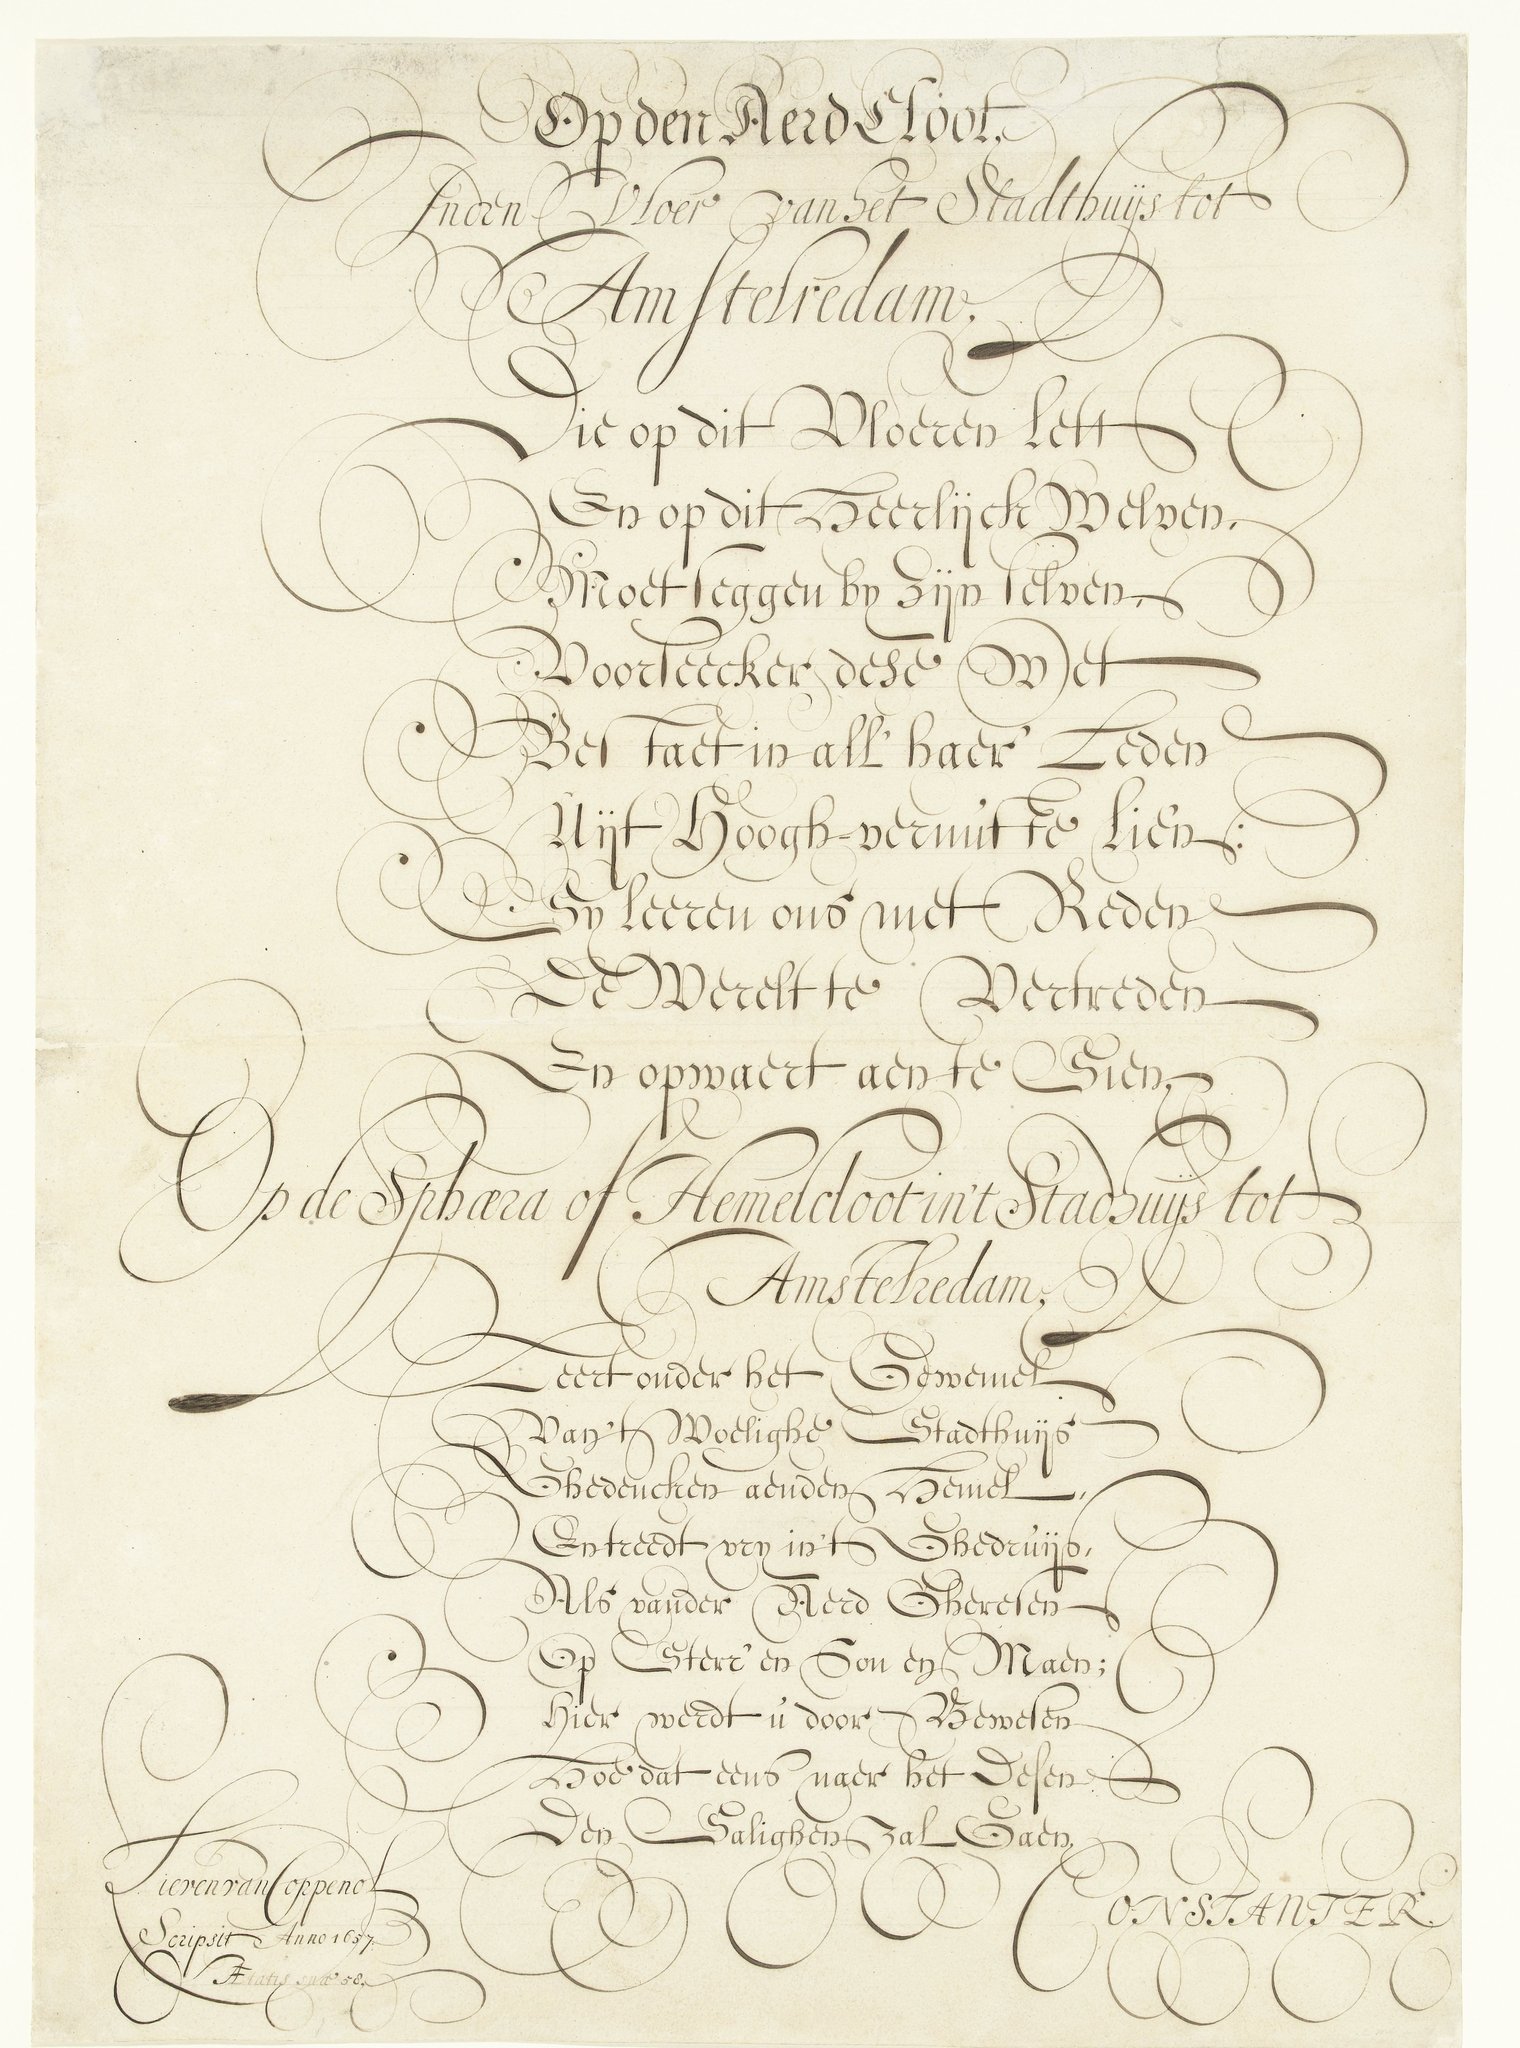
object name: calligraphy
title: Kalligrafisch schrift gewijd aan de kaarten van de aarde en de hemel in de vloer van het Amsterdamse Stadhuis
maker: lieven willemsz. coppenol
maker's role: draughtsman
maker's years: 1598-1668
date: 1657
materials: ink, paper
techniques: pen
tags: townhall, calligraphy, amsterdam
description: Pendant van 'Blad met kalligrafisch schrift', inventarisnummer RP-T-00-412.